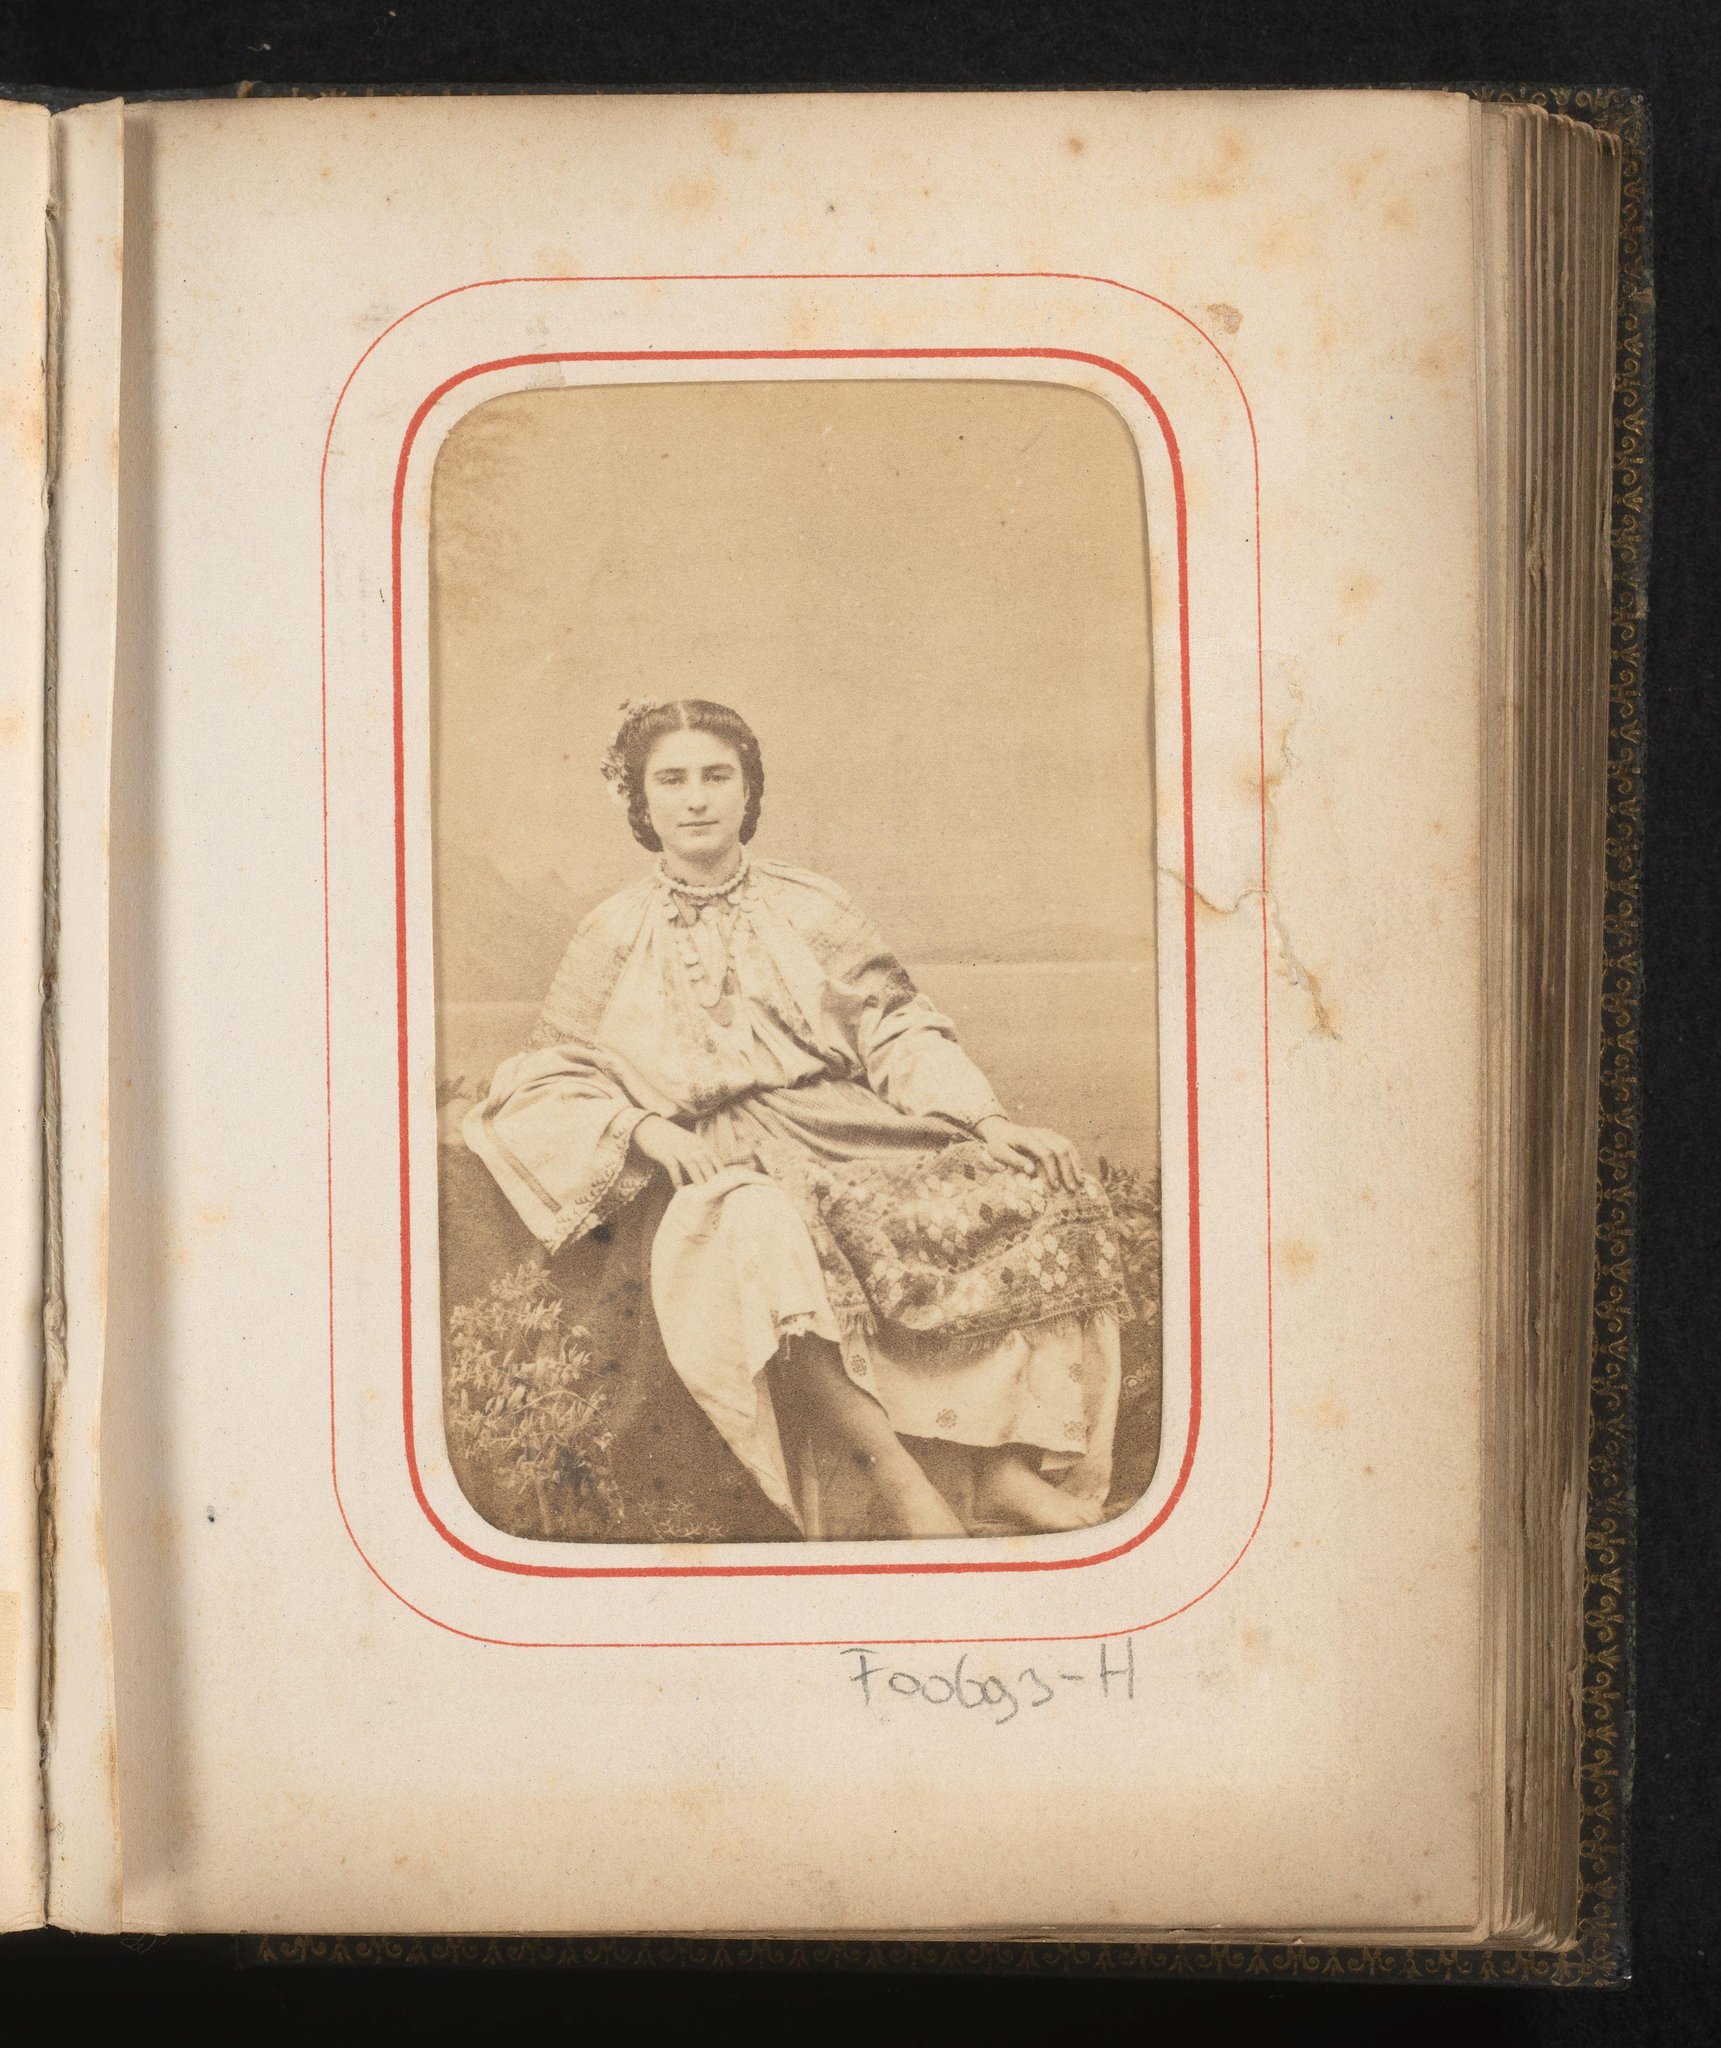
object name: album leaf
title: Portret van een zittende vrouw in Roemeense klederdracht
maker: carol popp de szathmari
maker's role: fotograaf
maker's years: 1812-1887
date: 1870-1890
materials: cardboard, photographic support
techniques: albumen print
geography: bucharest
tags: sitting figure - aa - female human figure, historical persons - bb - woman, folk costume, regional costume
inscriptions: inscription: ‘CHARLES SZATHMARI/ Peintre et Photographe de la Cour/ DE SALE PRINCE REGNANT/ des Principautées unies Roumaines./ (...)/ BUCAREST.’